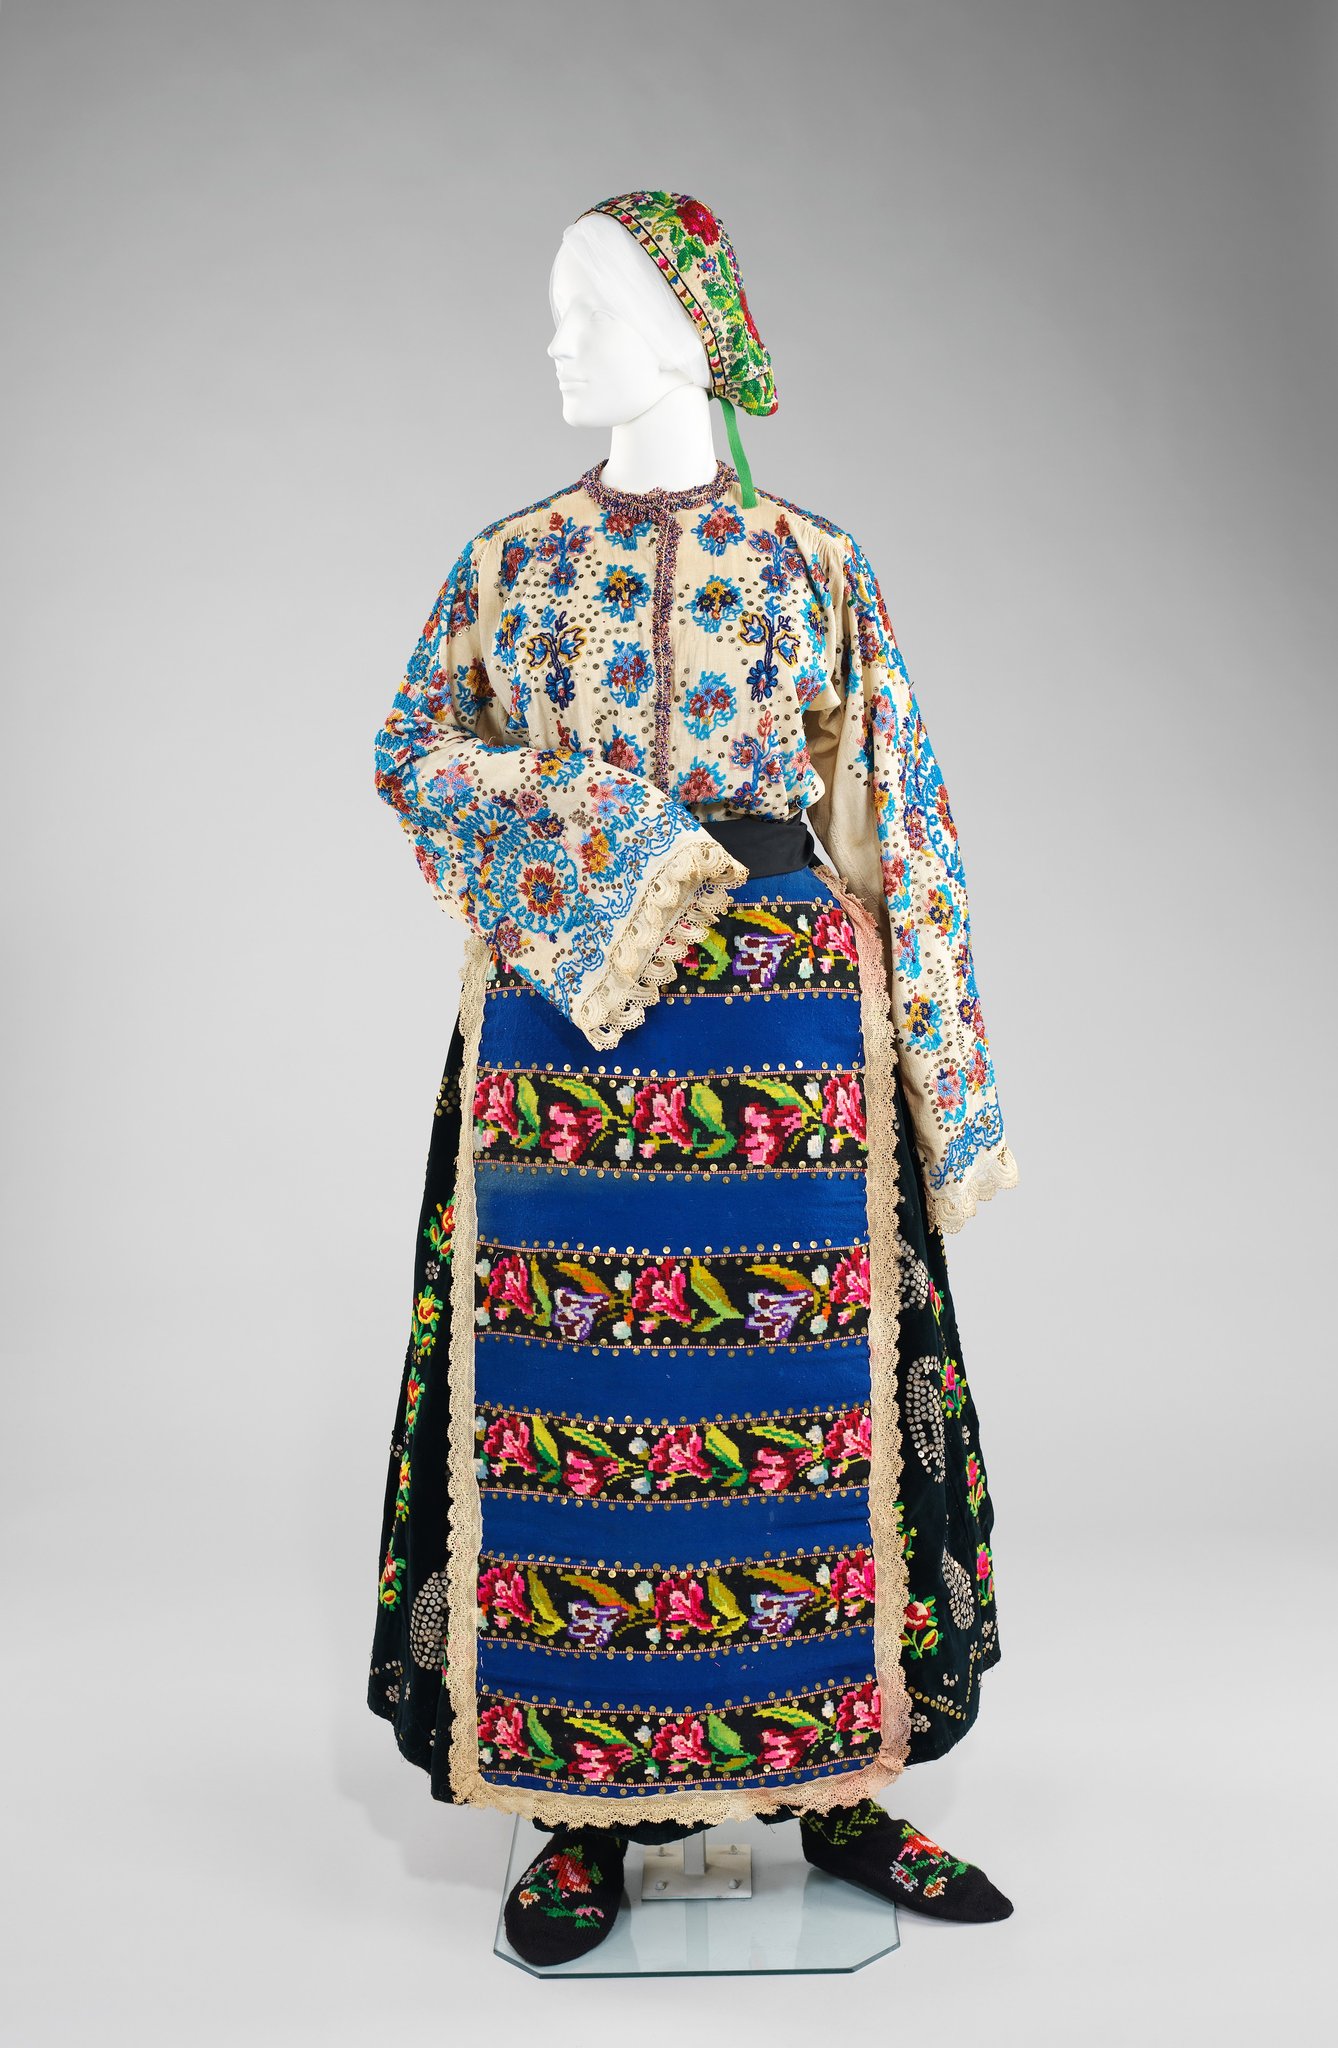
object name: ensemble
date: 1867-1900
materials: cotton, glass, linen, metal, wool